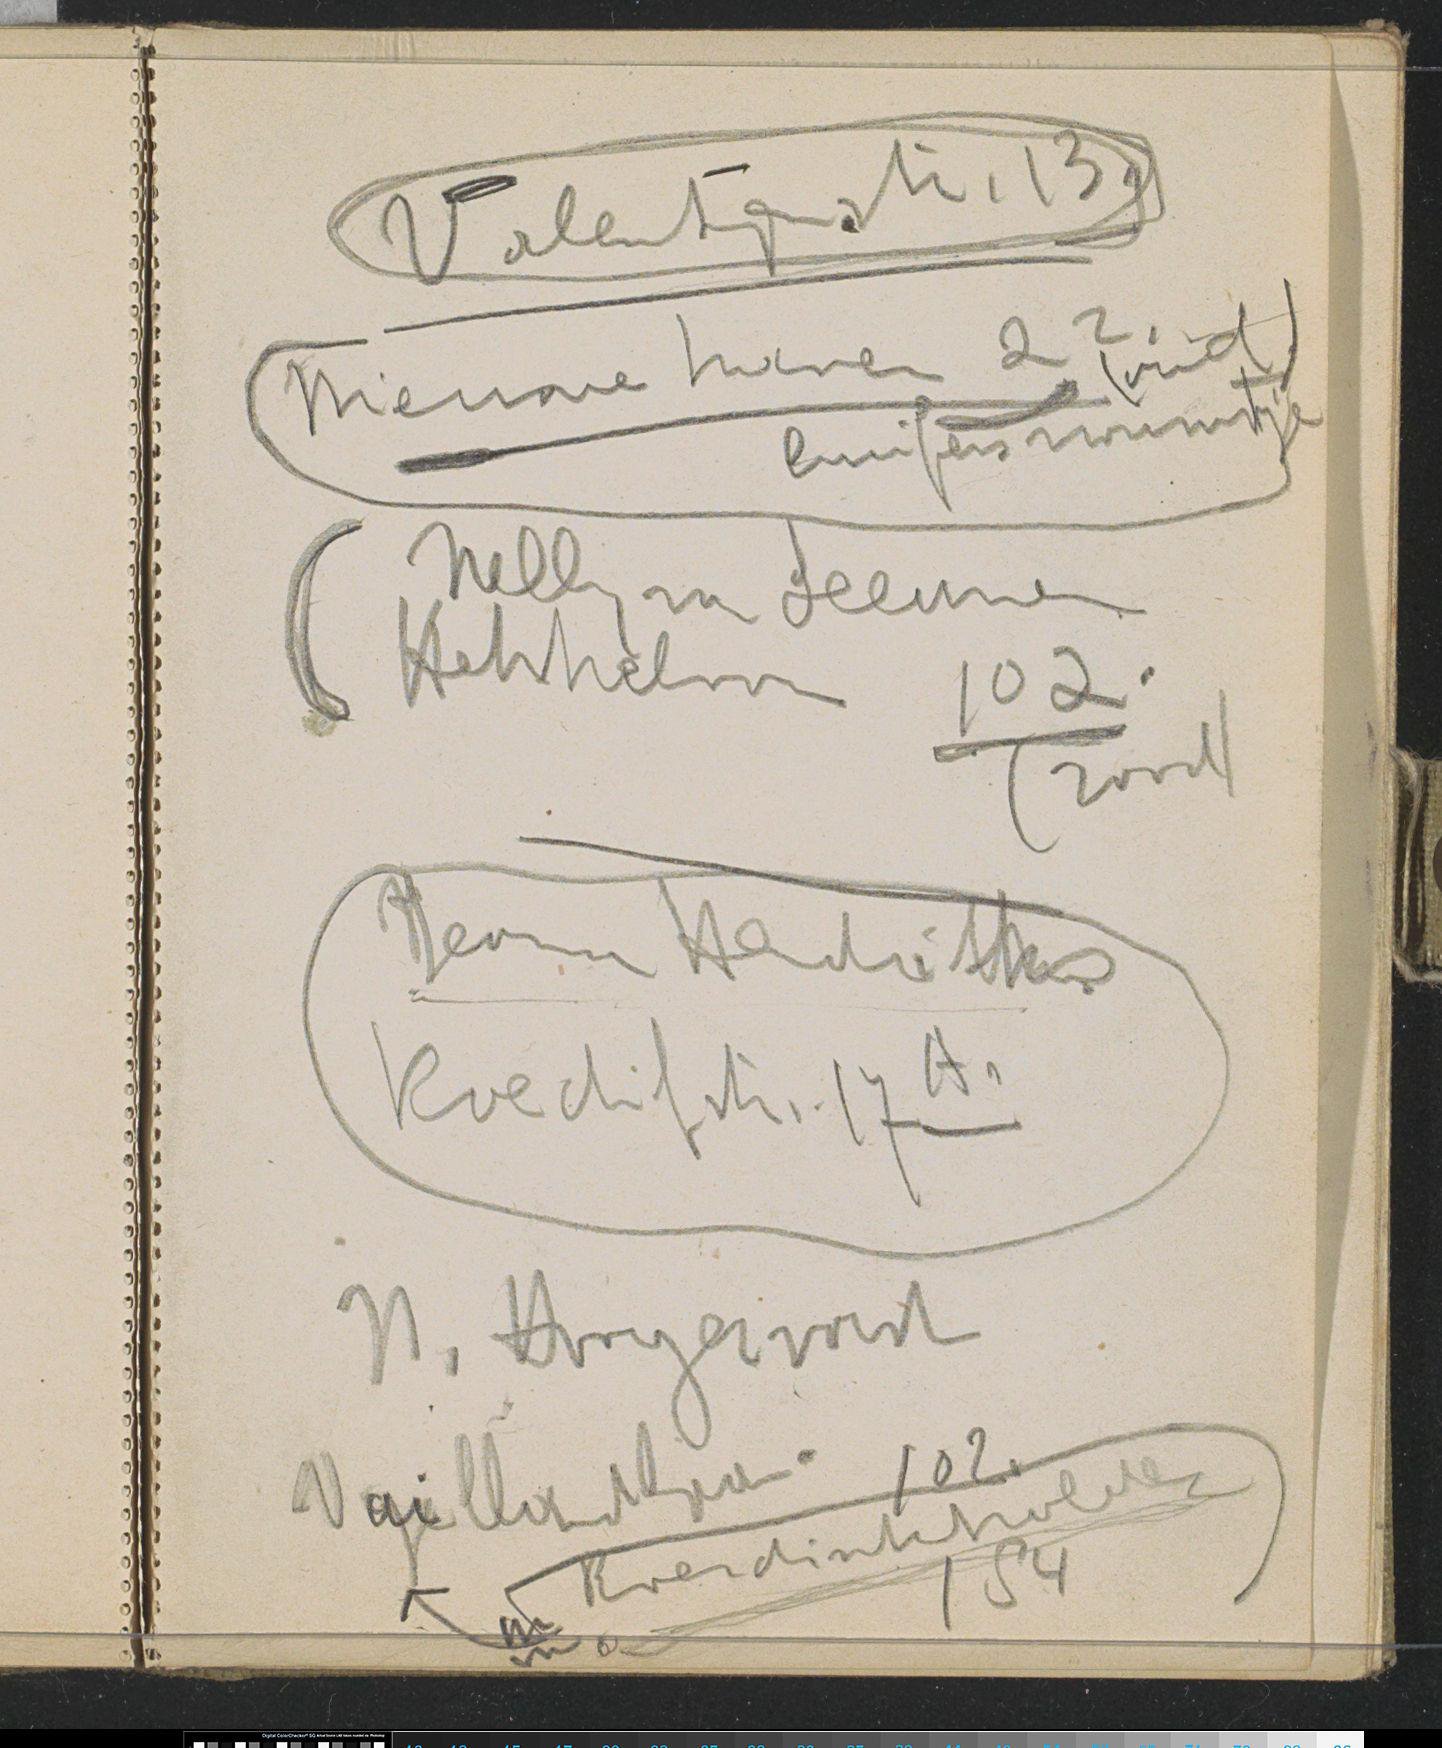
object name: sketchbook leaf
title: Namen en adressen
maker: reijer stolk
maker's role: draughtsman, print maker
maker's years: 1896-1945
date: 1906-1945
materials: paper, pencil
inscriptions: annotation: ‘[...]’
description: Blad 51 recto uit een schetsboek met 53 bladen.